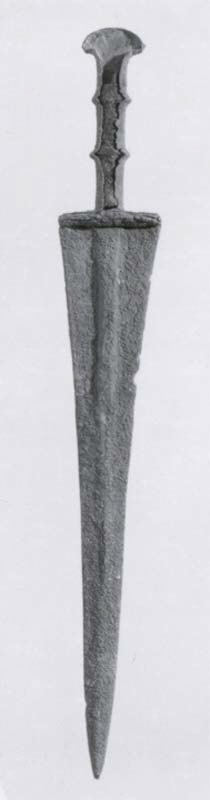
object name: dagger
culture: iranian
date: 1000-801 BCE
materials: bronze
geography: northwestern iran, caspian region